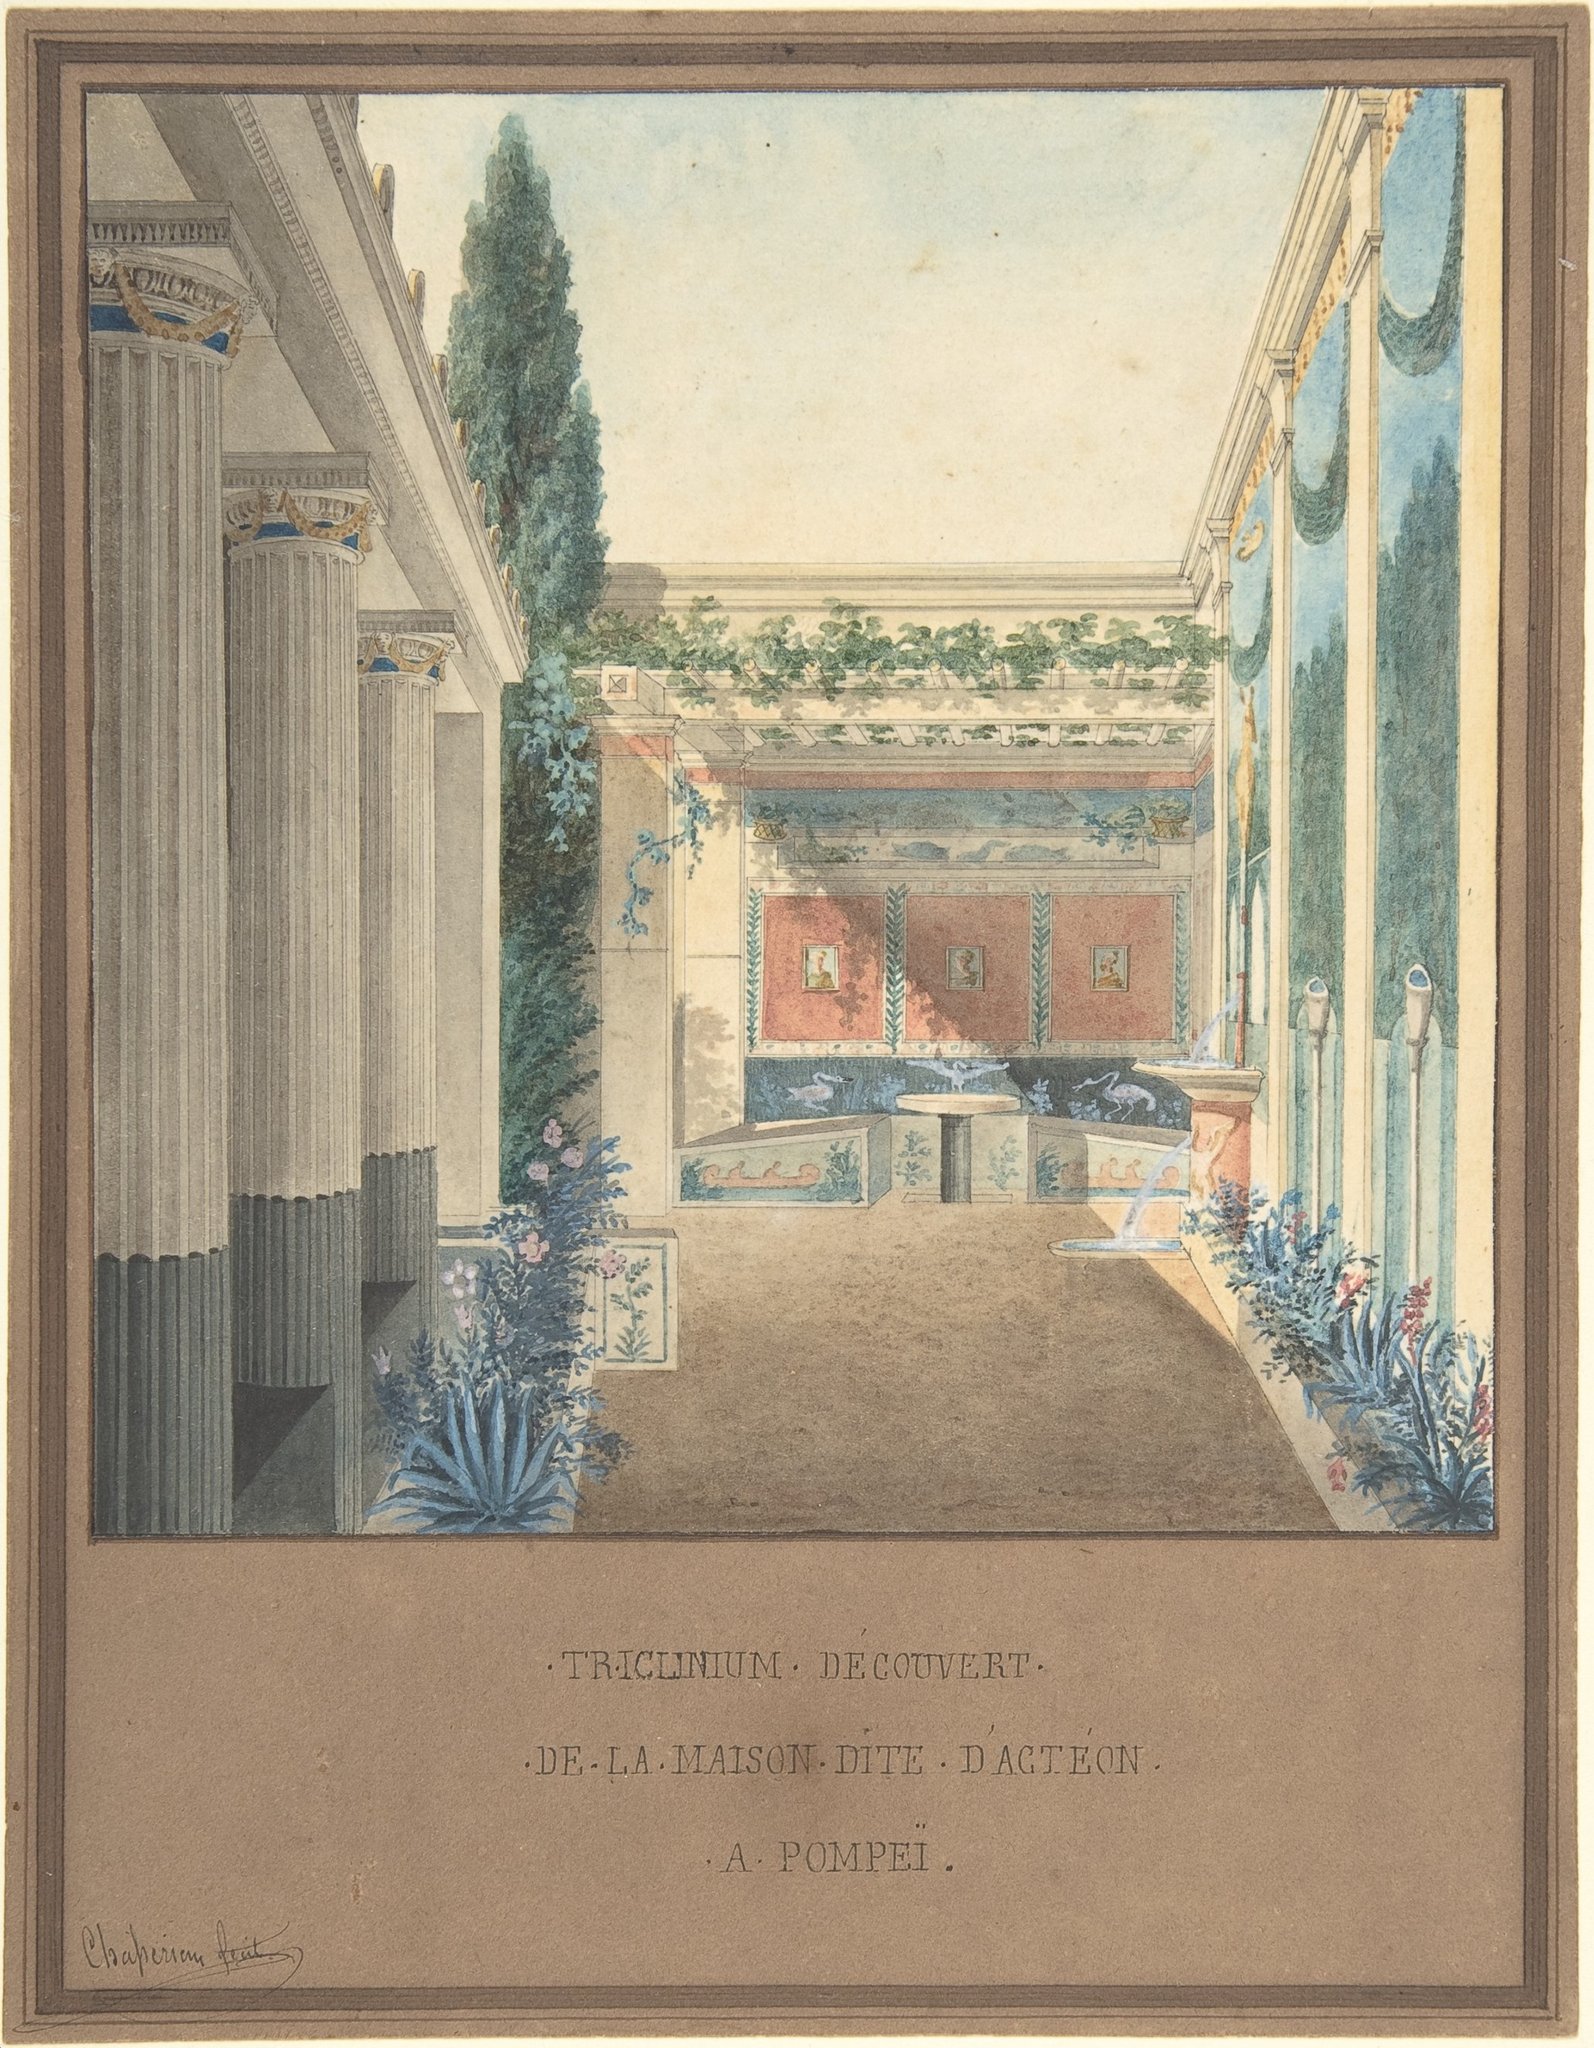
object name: drawing ornament architetecture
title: Triclinium, Excavated in the House of Actaeon, Pompeii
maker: charles frédéric chassériau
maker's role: artist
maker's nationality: french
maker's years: 1802-1896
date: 1824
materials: ink, watercolor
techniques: pen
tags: buildings,columns